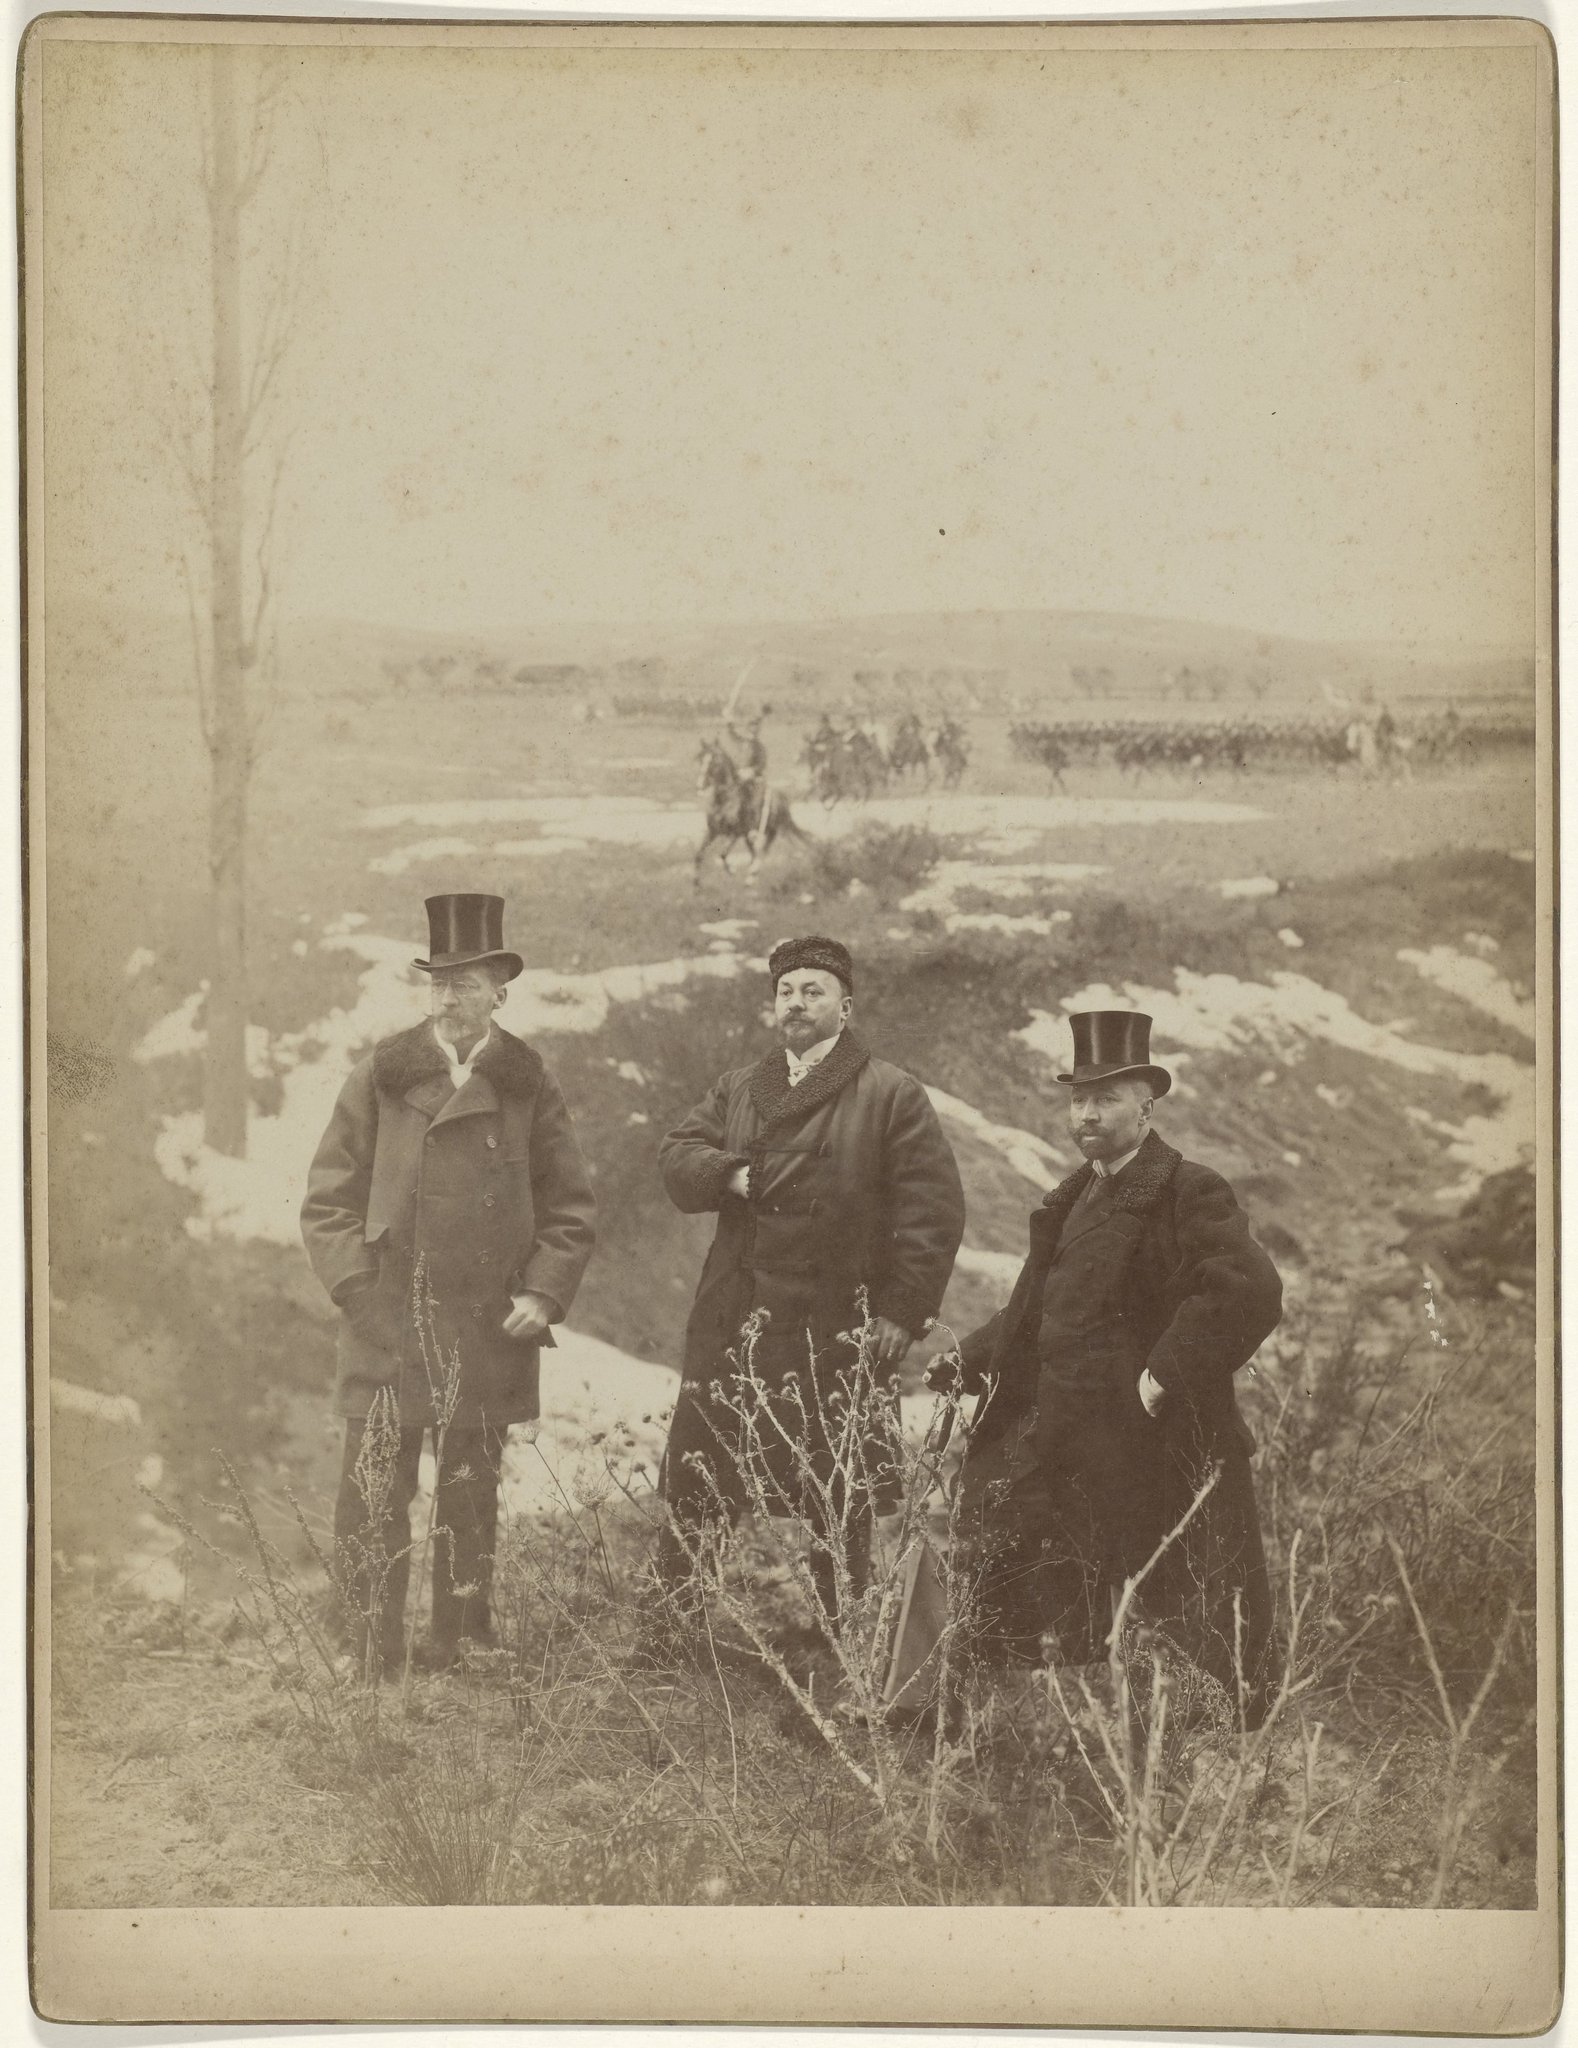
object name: photograph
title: Adam Styka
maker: Anonymous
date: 1880-1900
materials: cardboard, photographic support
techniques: albumen print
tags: historical persons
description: de mannen staan voor een achtergronddoek met daarop een slagveld